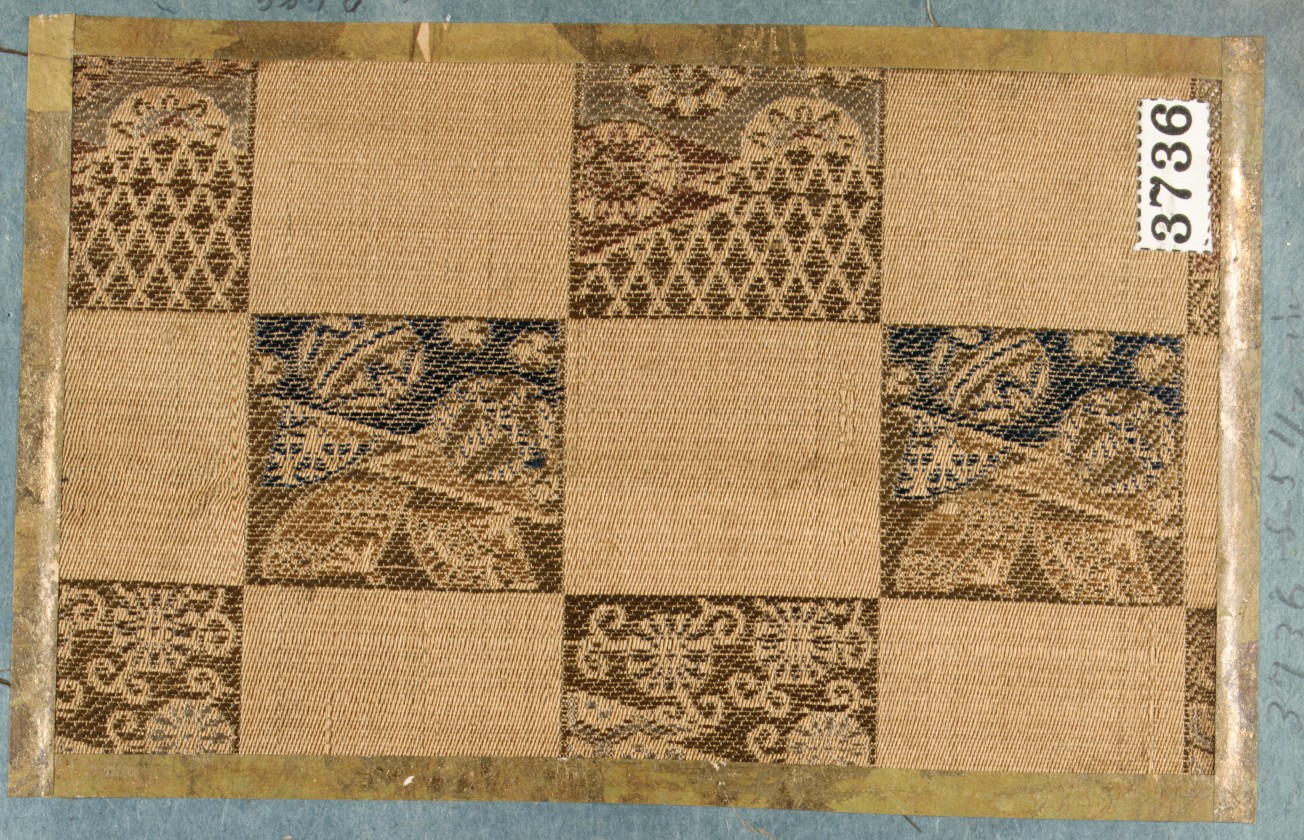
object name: sample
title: Textile Sample from Sample Book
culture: japanese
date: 1801-1900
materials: silk